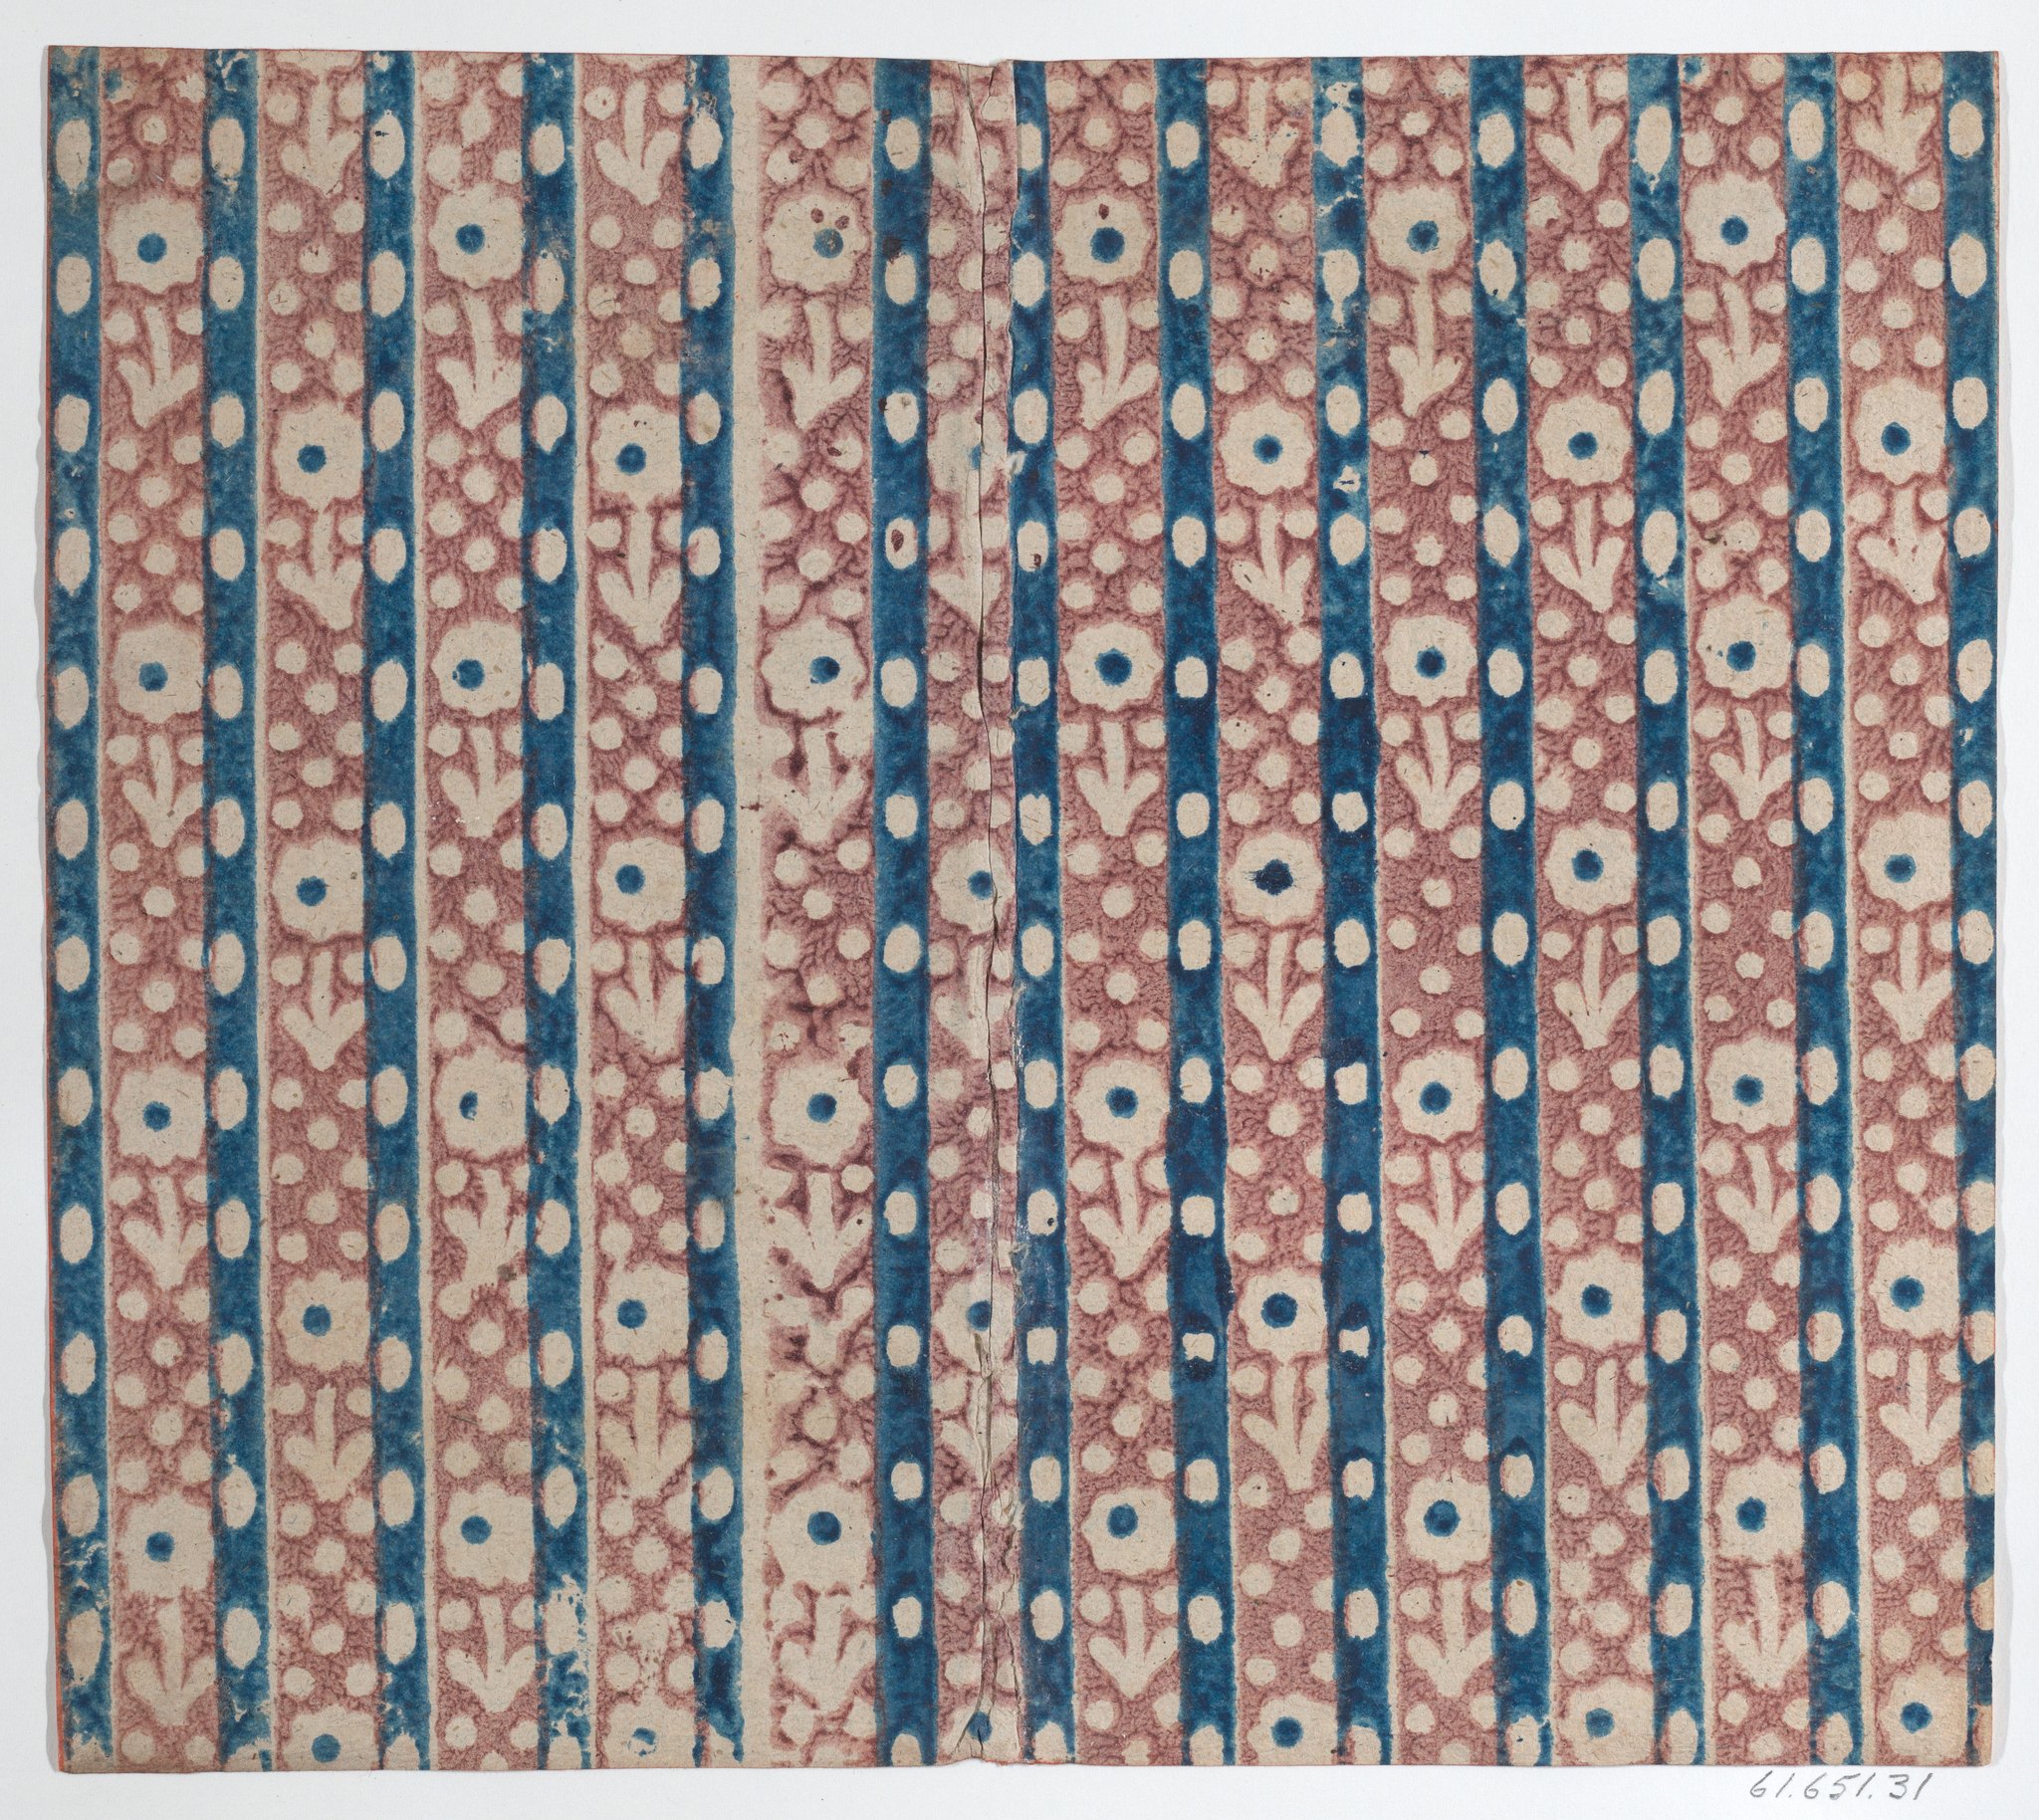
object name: print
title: Sheet with stripe and floral pattern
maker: Anonymous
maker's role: artist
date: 1701-1800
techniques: relief print